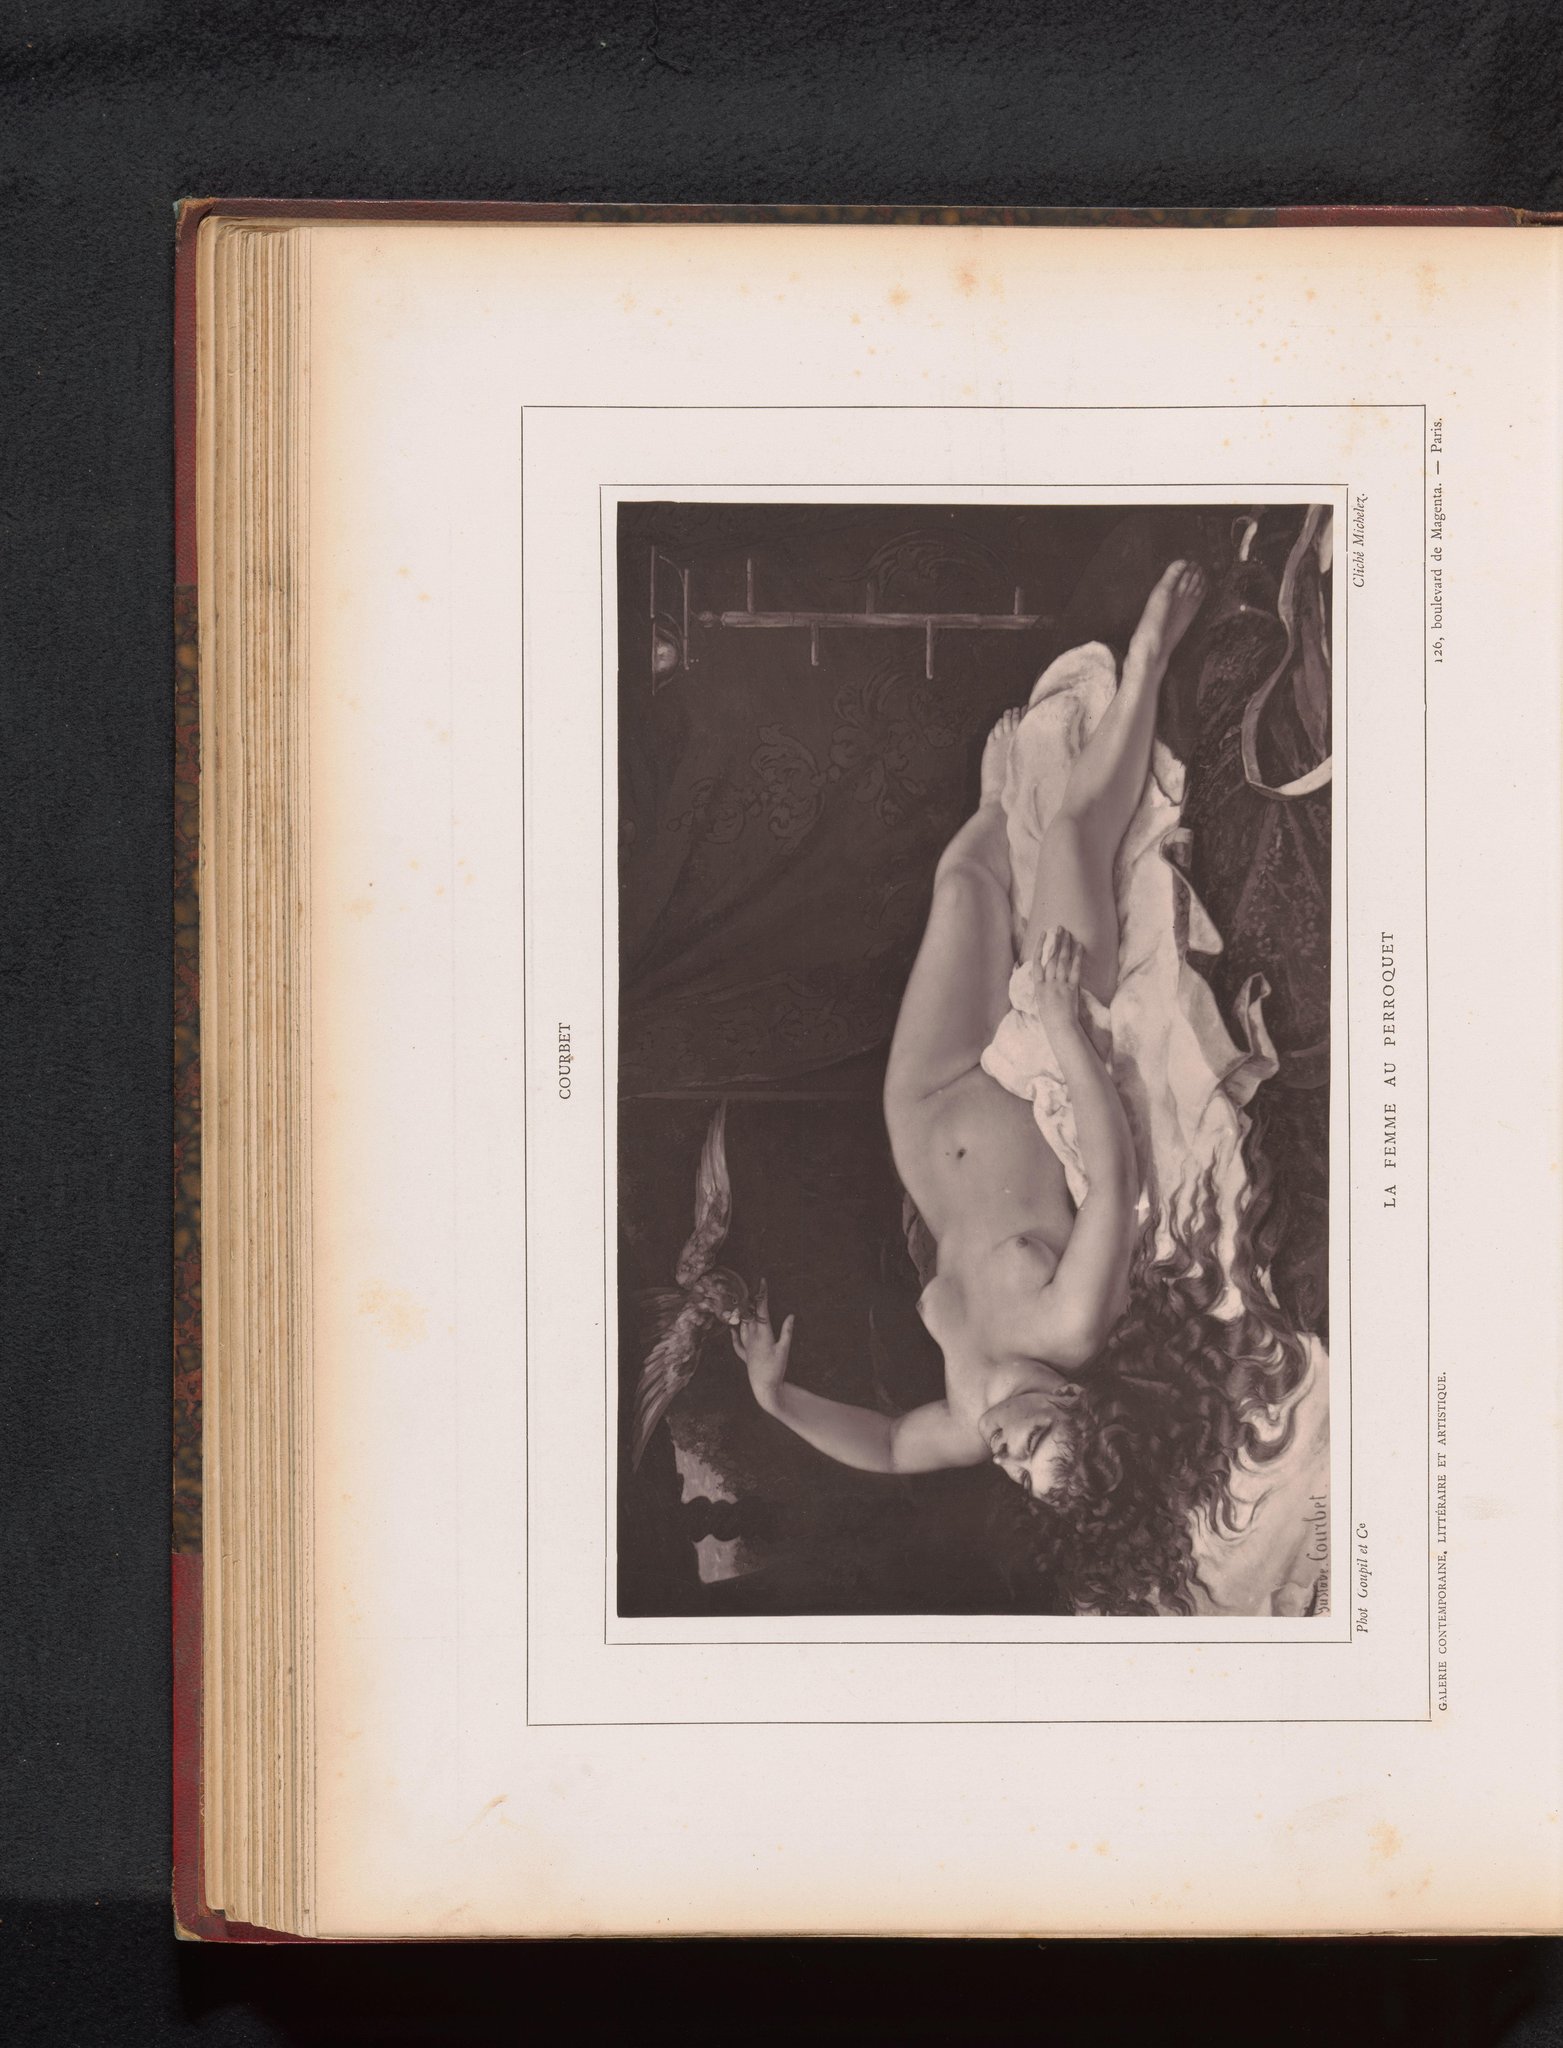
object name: reproduction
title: Reproductie van Vrouw met een papegaai door Gustave Courbet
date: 1873-1878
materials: paper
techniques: woodburytype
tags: ornamental birds: parrot, the (nude) human figure; 'corpo humano' (ripa) - aa - female human figure, lying figure - aa - female human figure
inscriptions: inscription: ‘Galerie Contemporaine, Littéraire, Artistique/ 126, boulevard Magenta, Paris.’